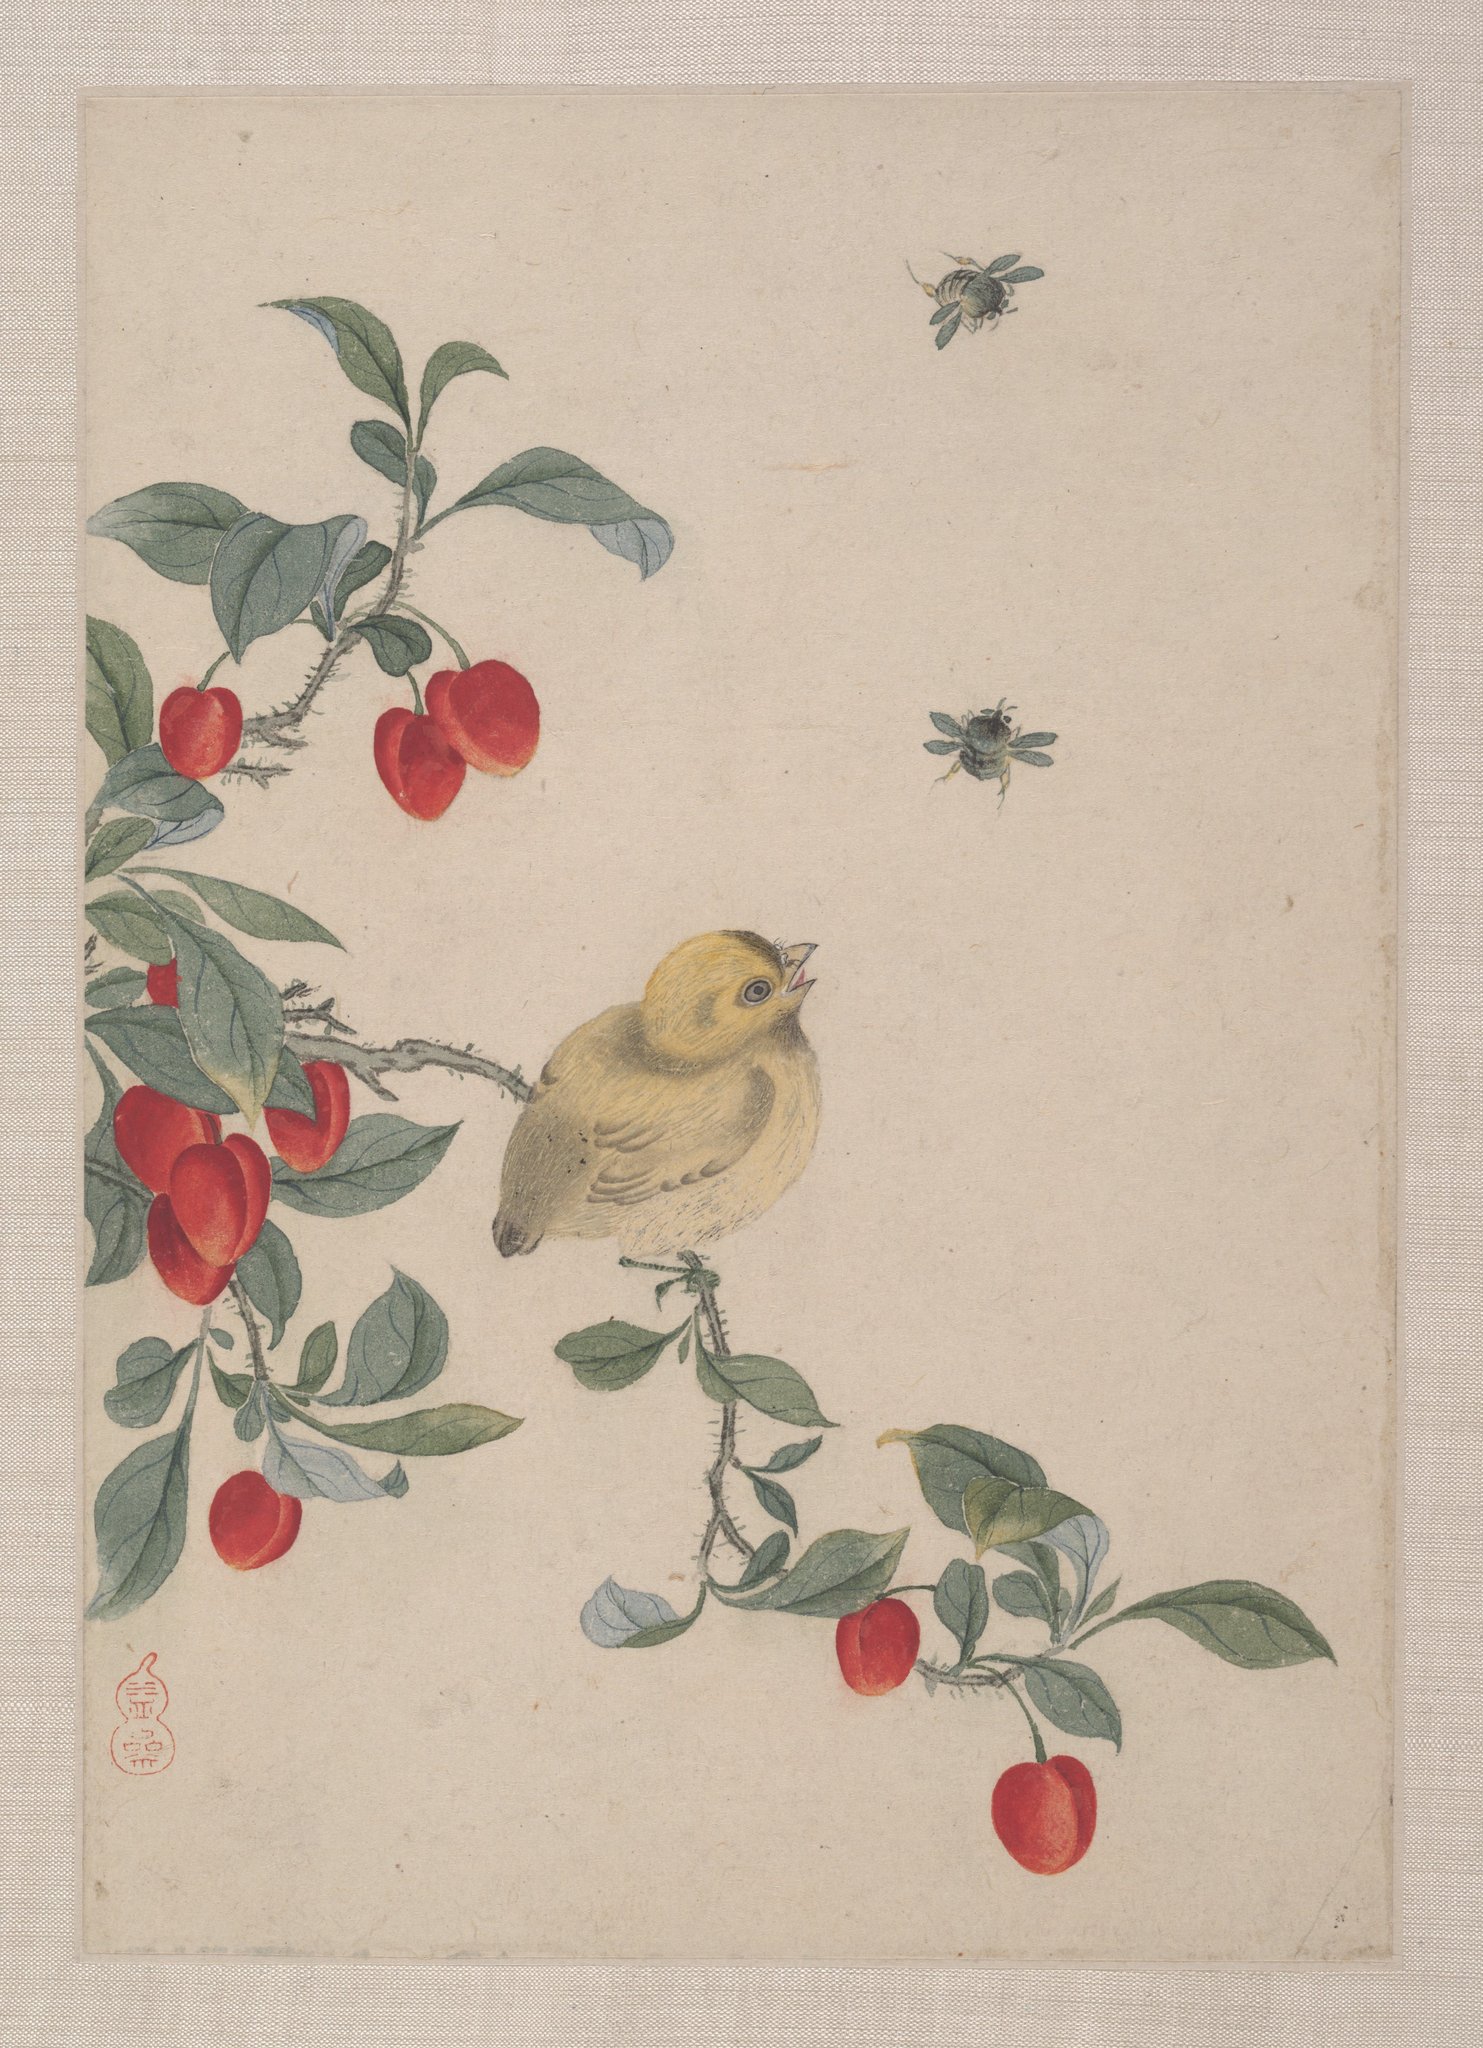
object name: album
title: Birds, Insects and Flowers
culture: chinese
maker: yi zhai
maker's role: artist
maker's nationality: chinese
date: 1801-1900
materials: ink, paper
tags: birds,insects,flowers